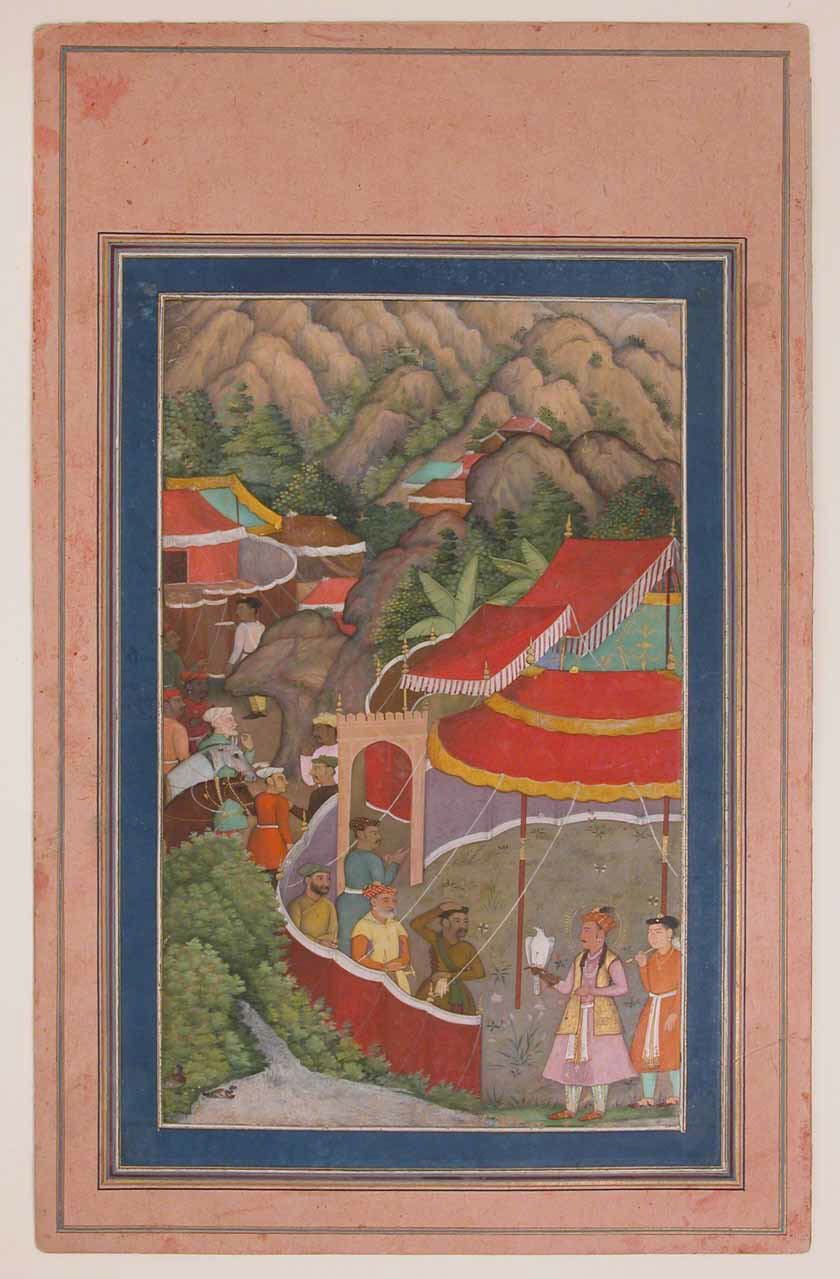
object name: illustrated album leaf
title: "Encampment in the Hills: Jahangir with Falcon", Folio from a Manuscript of the Akbarnama. Folio from the Davis Album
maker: abu'l fazl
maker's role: author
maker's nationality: indian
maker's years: 1556-1602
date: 1601-1633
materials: gold, ink, paper, watercolor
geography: india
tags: falcons,tents,historical figures,men,hills